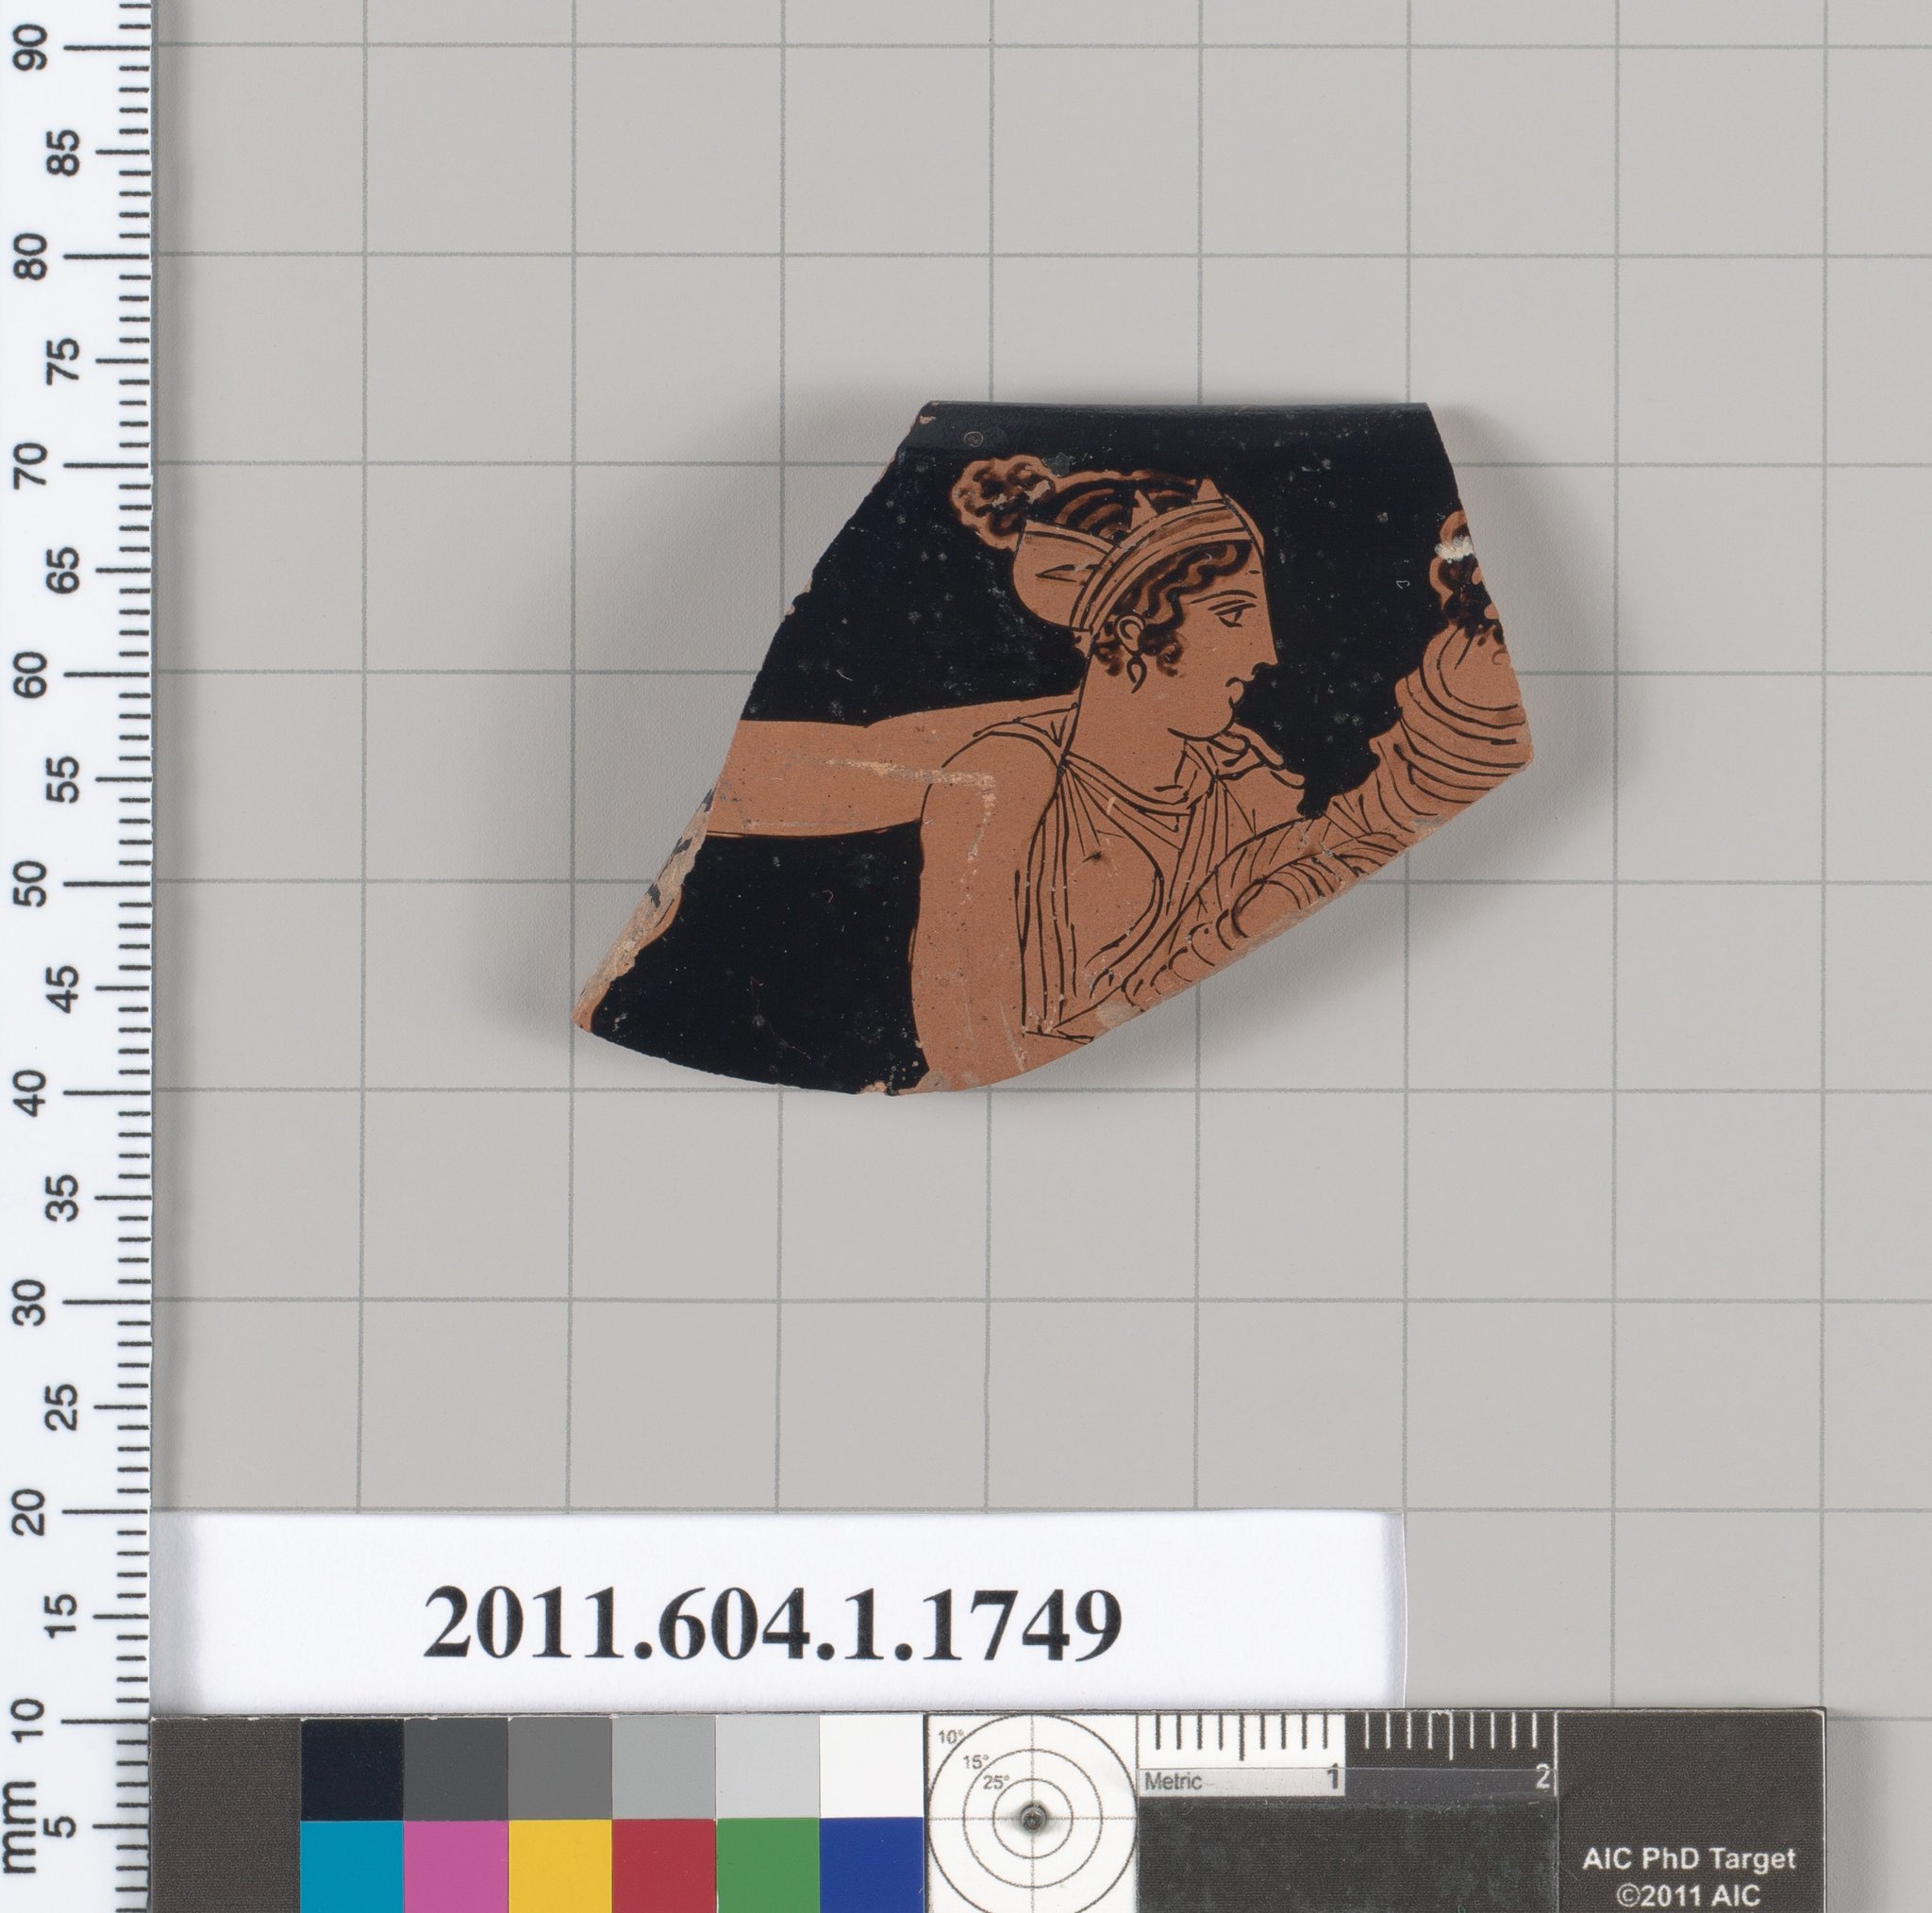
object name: kylix fragment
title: Terracotta rim fragment of a kylix (drinking cup)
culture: greek, attic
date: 467-435 BCE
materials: terracotta